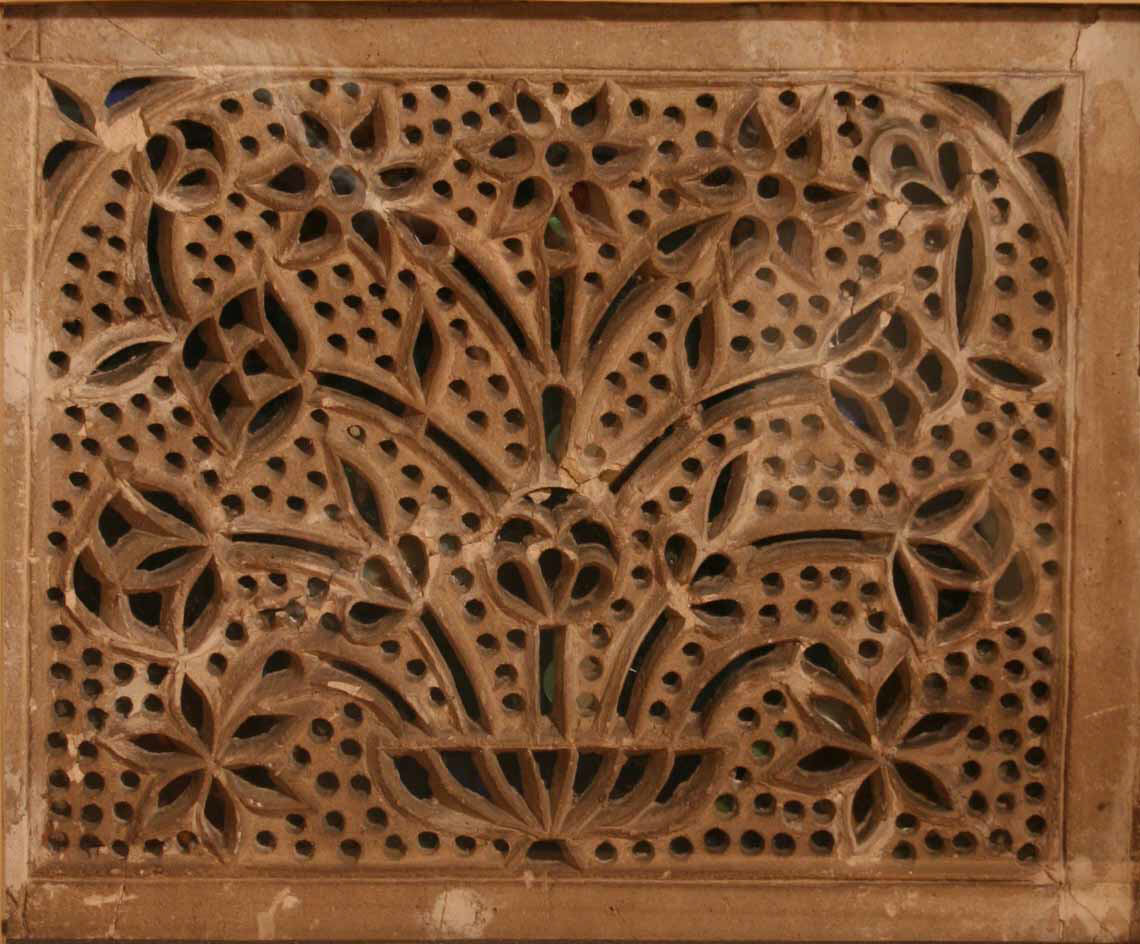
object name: window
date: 1601-1700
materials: gypsum, glass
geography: egypt or syria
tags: flowers